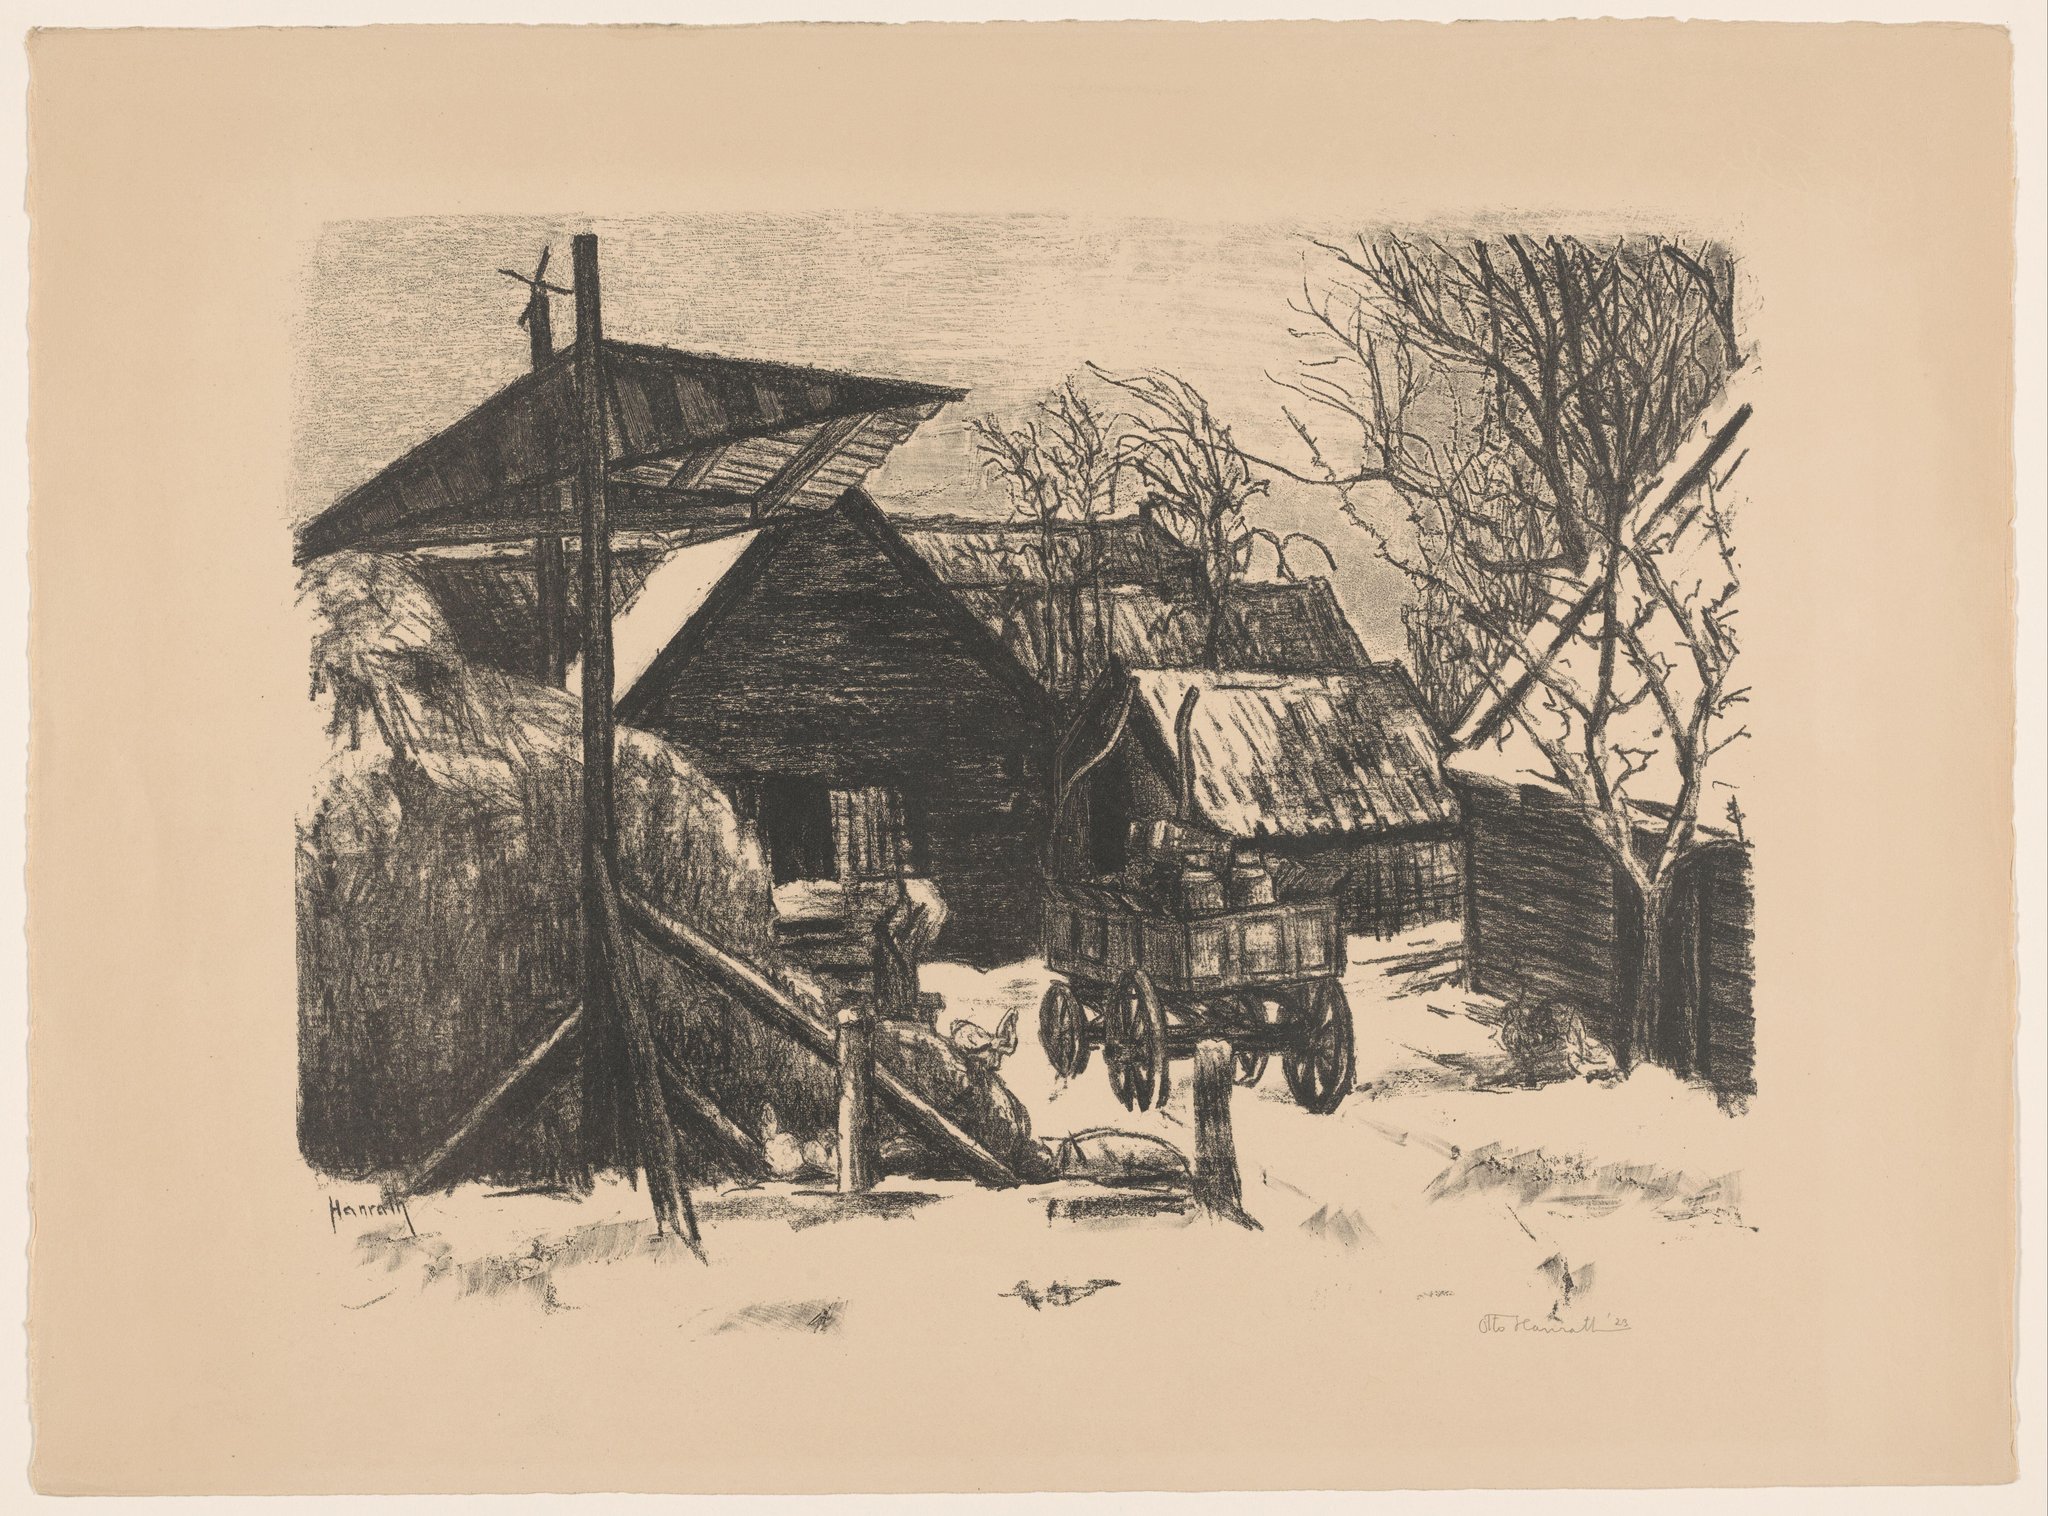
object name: print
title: Boerenerf in de sneeuw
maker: otto hanrath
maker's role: print maker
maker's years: 1882-1944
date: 1923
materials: paper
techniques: lithograph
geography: netherlands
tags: snow, (farm) wagon, freight wagon, cart, farm (building)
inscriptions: collector's mark: Lugt 2228